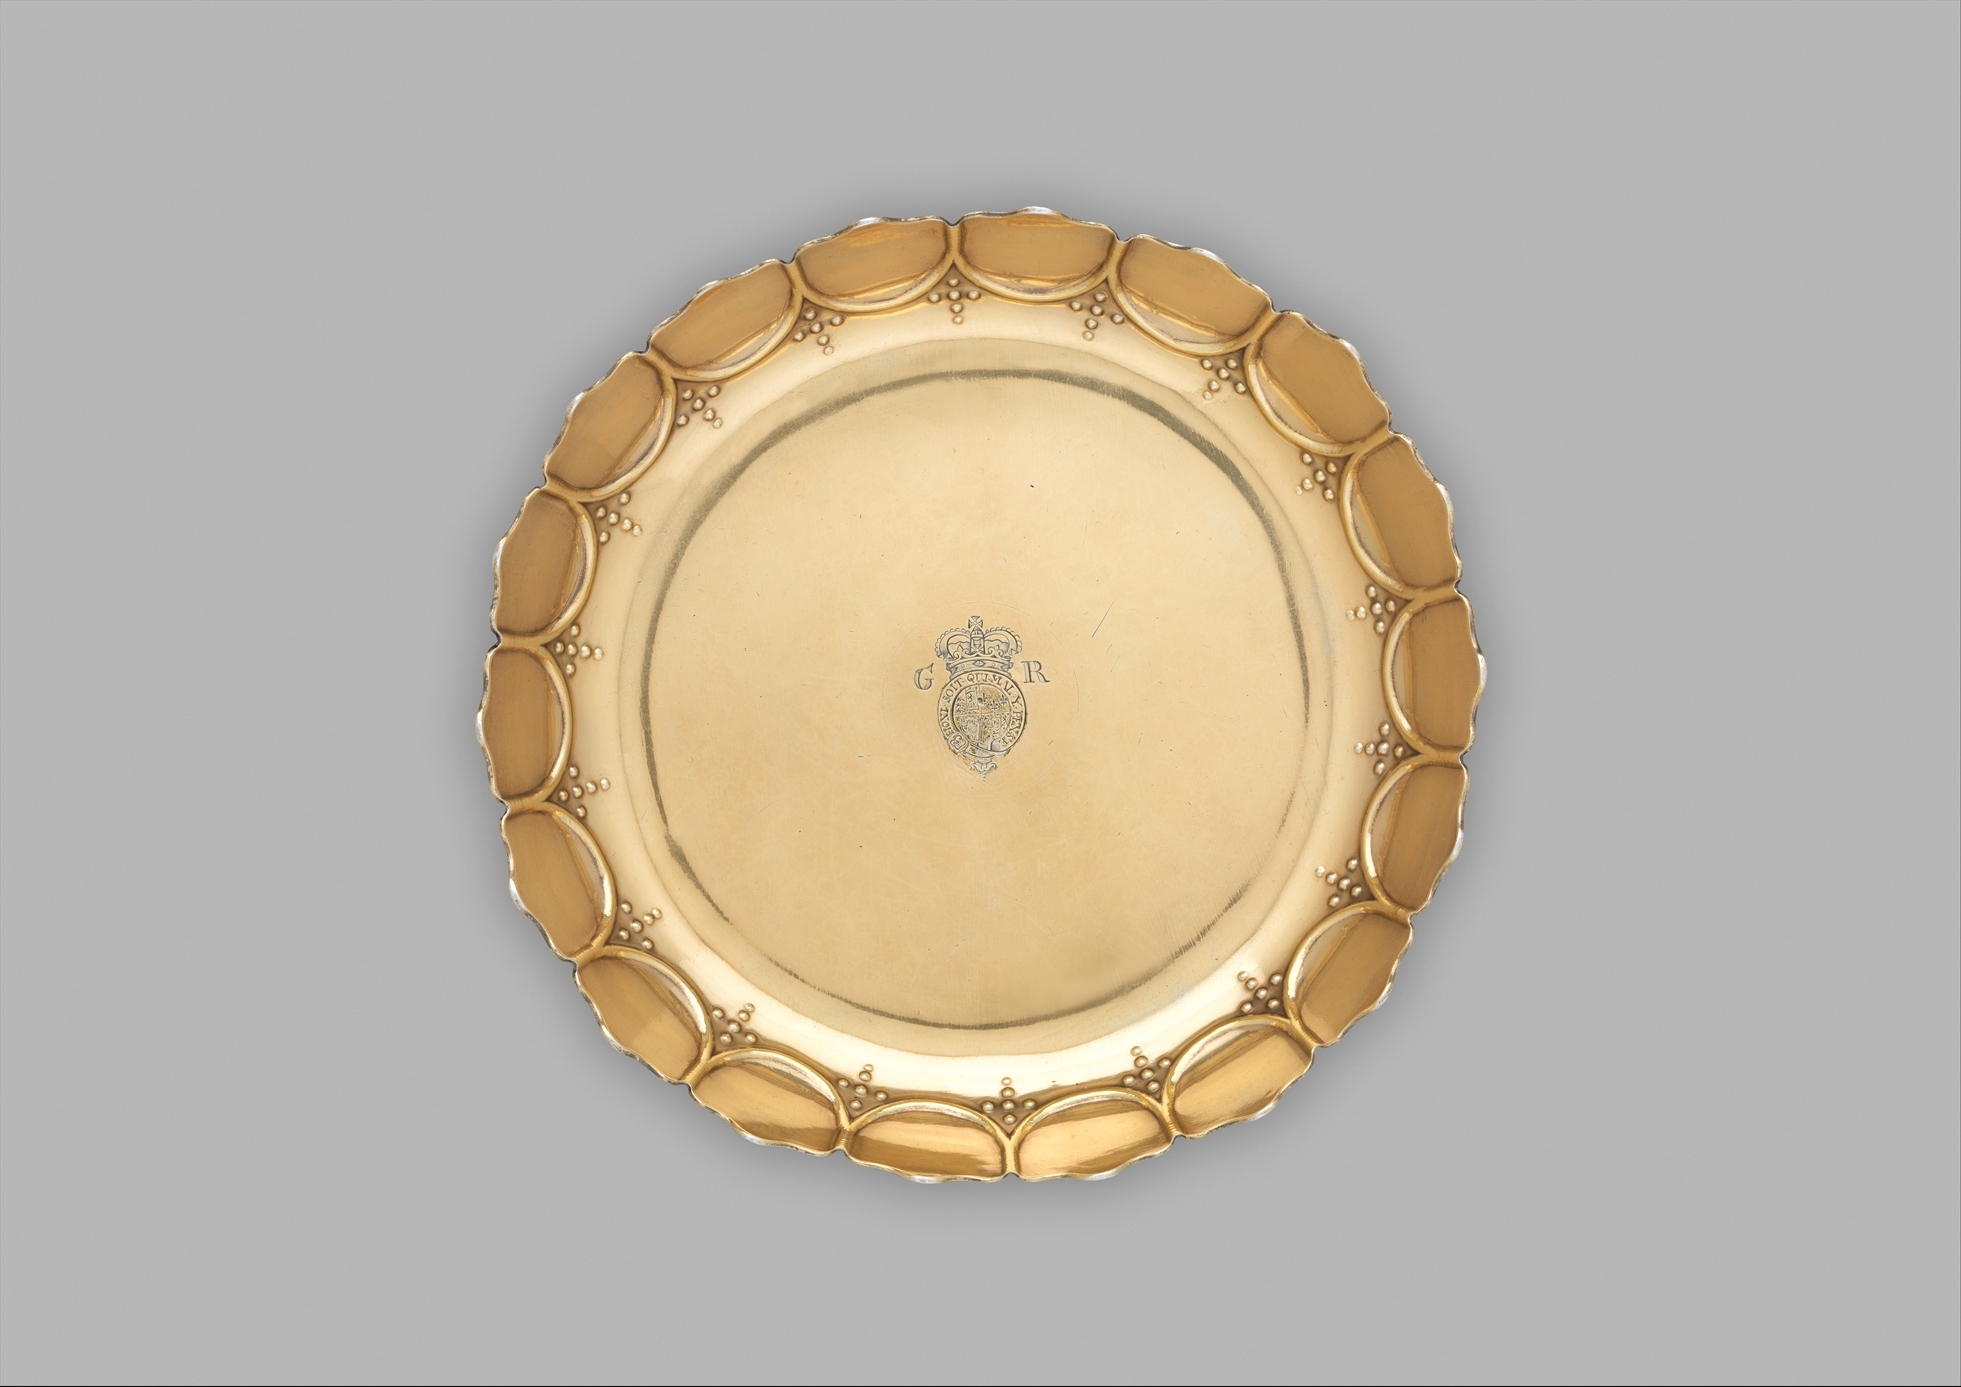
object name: dish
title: Dish (one of a pair) (part of a set)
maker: lewis mettayer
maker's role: maker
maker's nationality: british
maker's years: 1640-1740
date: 1714-1715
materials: gilt silver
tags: coat of arms